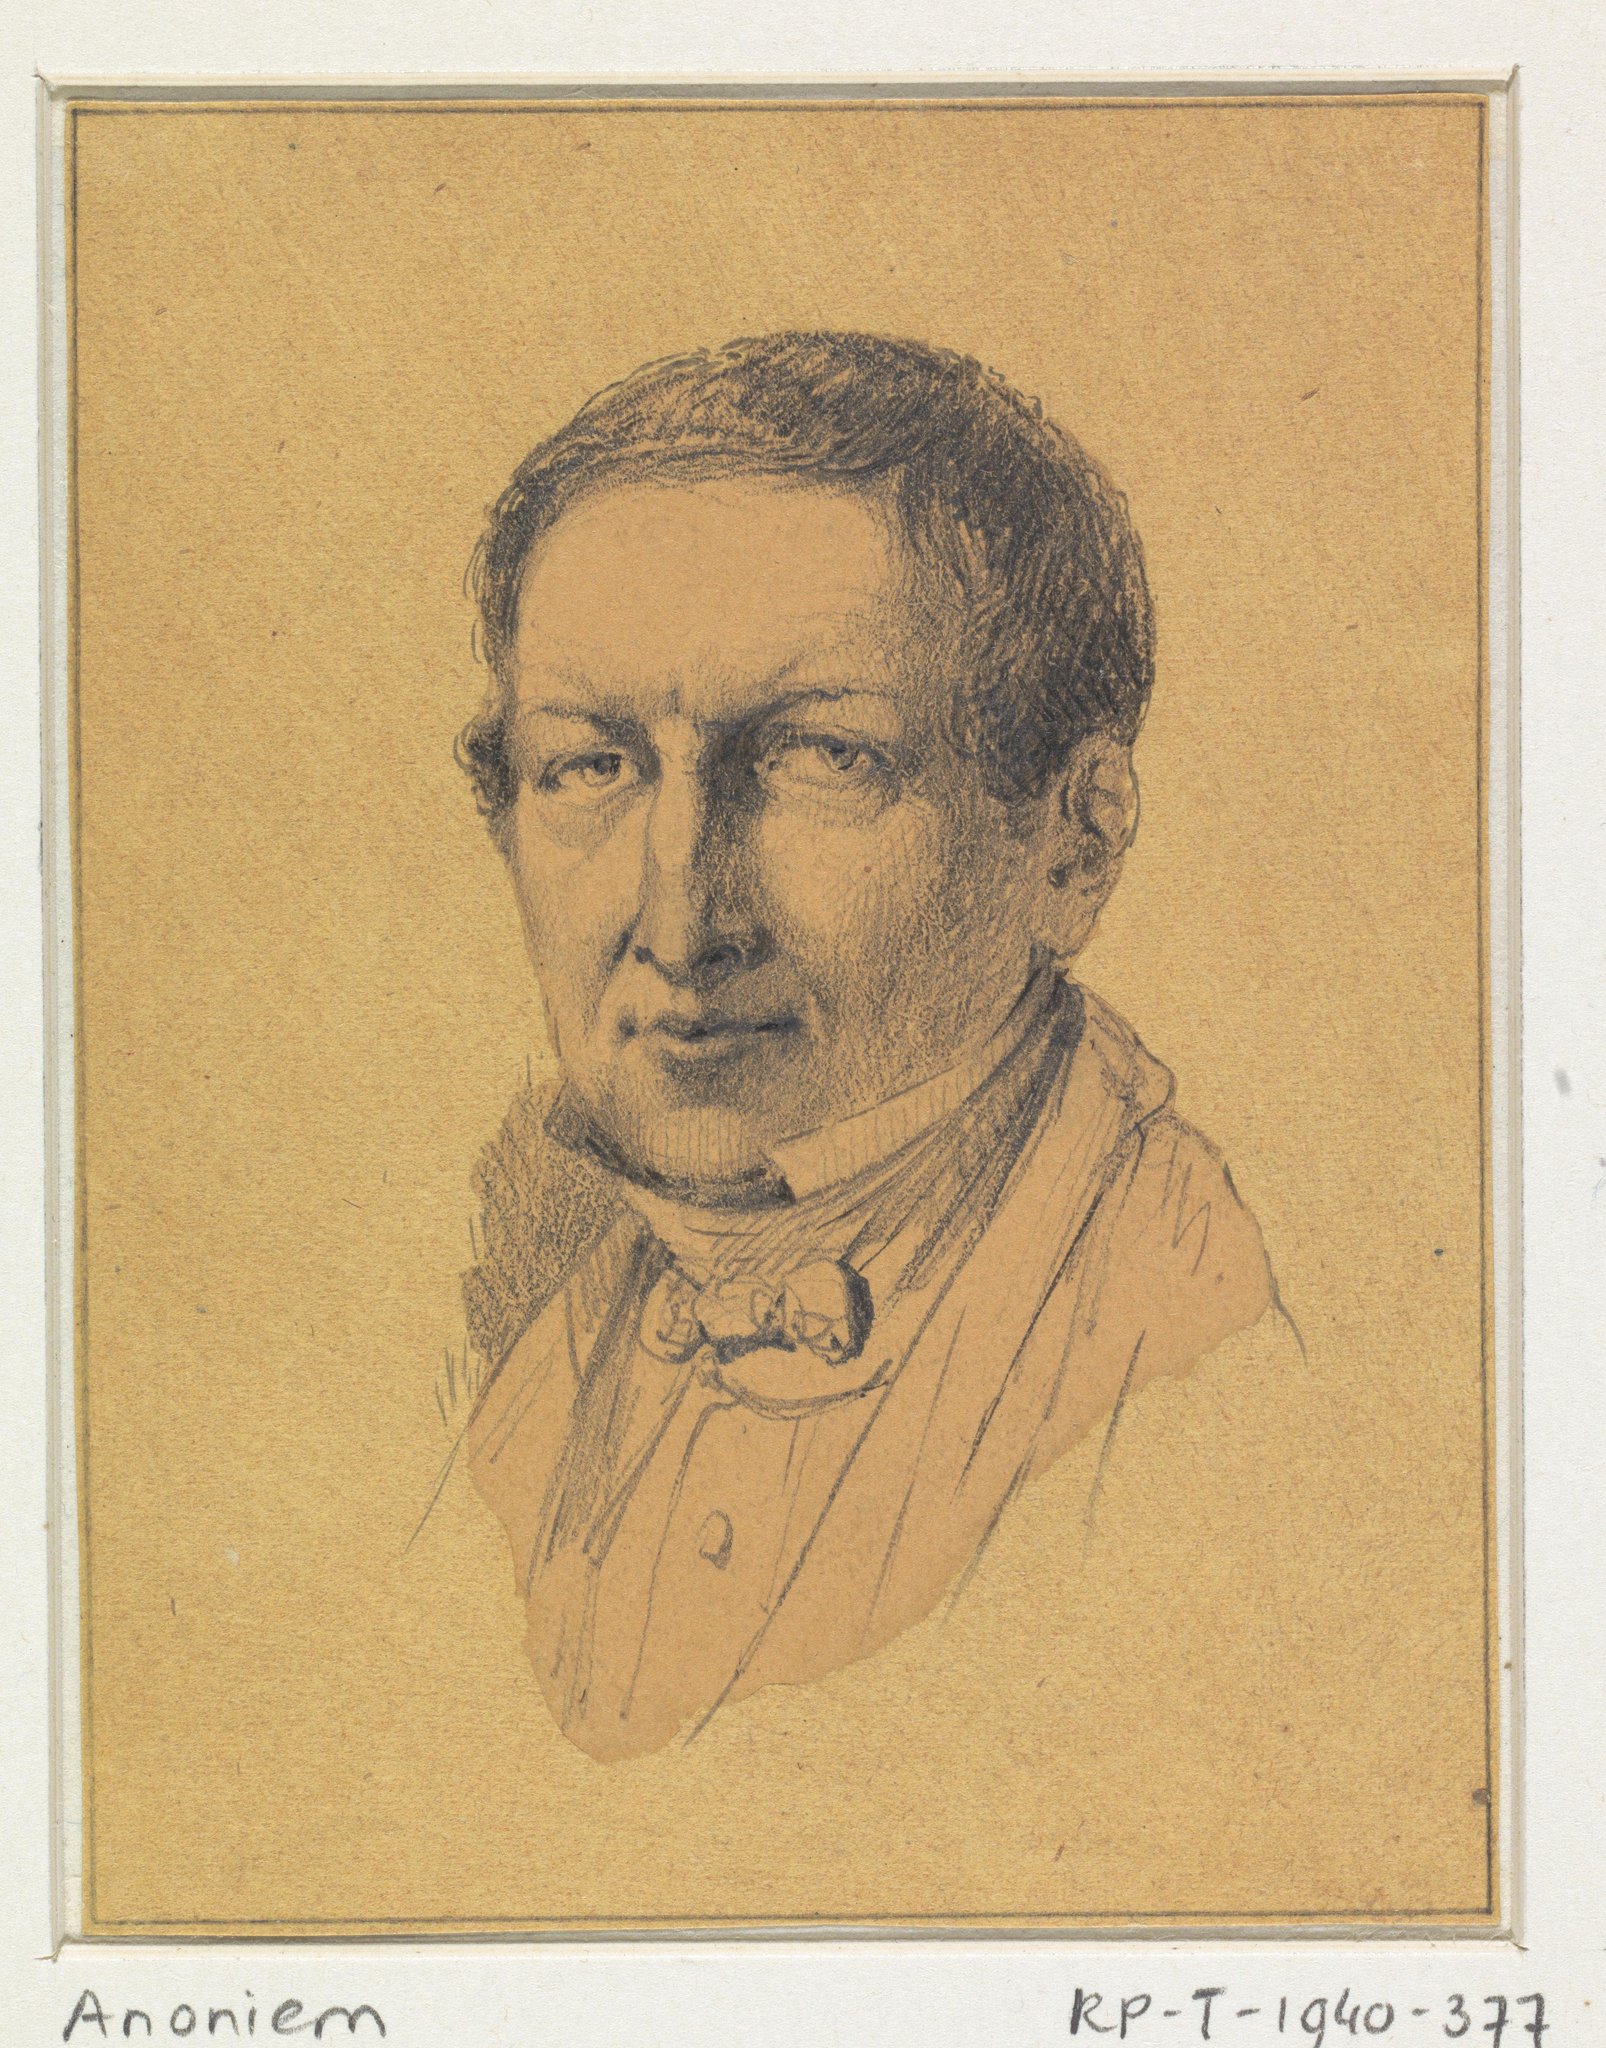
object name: drawing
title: Portret van Hendrik Jozef Franciscus van der Poorten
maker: Anonymous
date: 1799-1924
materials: chalk, pencil, paper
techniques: brush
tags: antwerp, print maker, draughtsman, hendrik jozef franciscus van der poorten, historical persons, portrait, self-portrait of artist